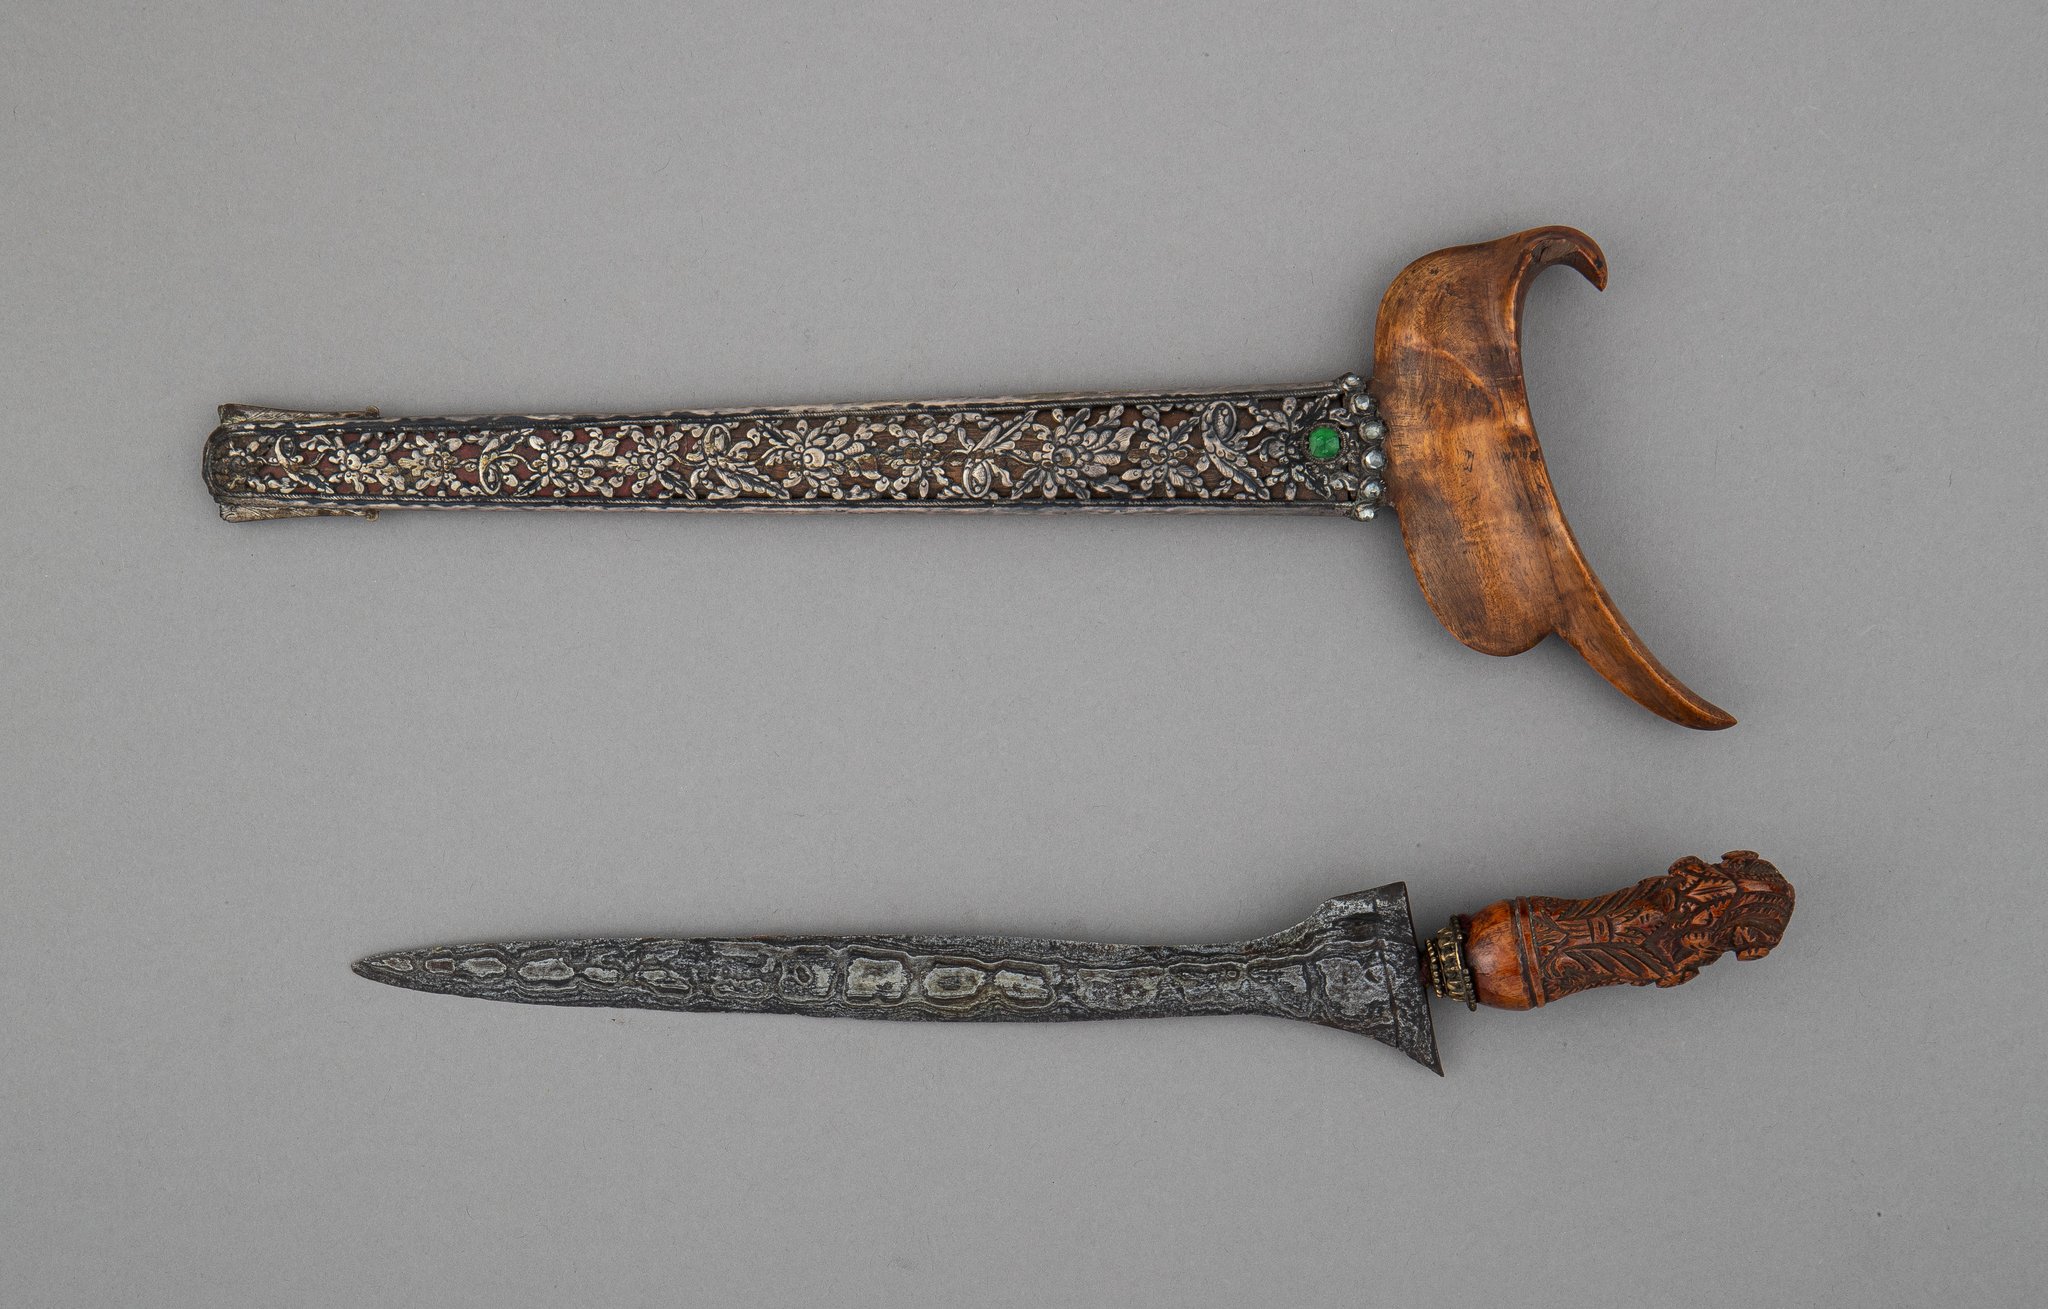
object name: kris with sheath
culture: madurese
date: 1501-1900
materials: brass, paste, silver, steel, wood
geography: indonesia